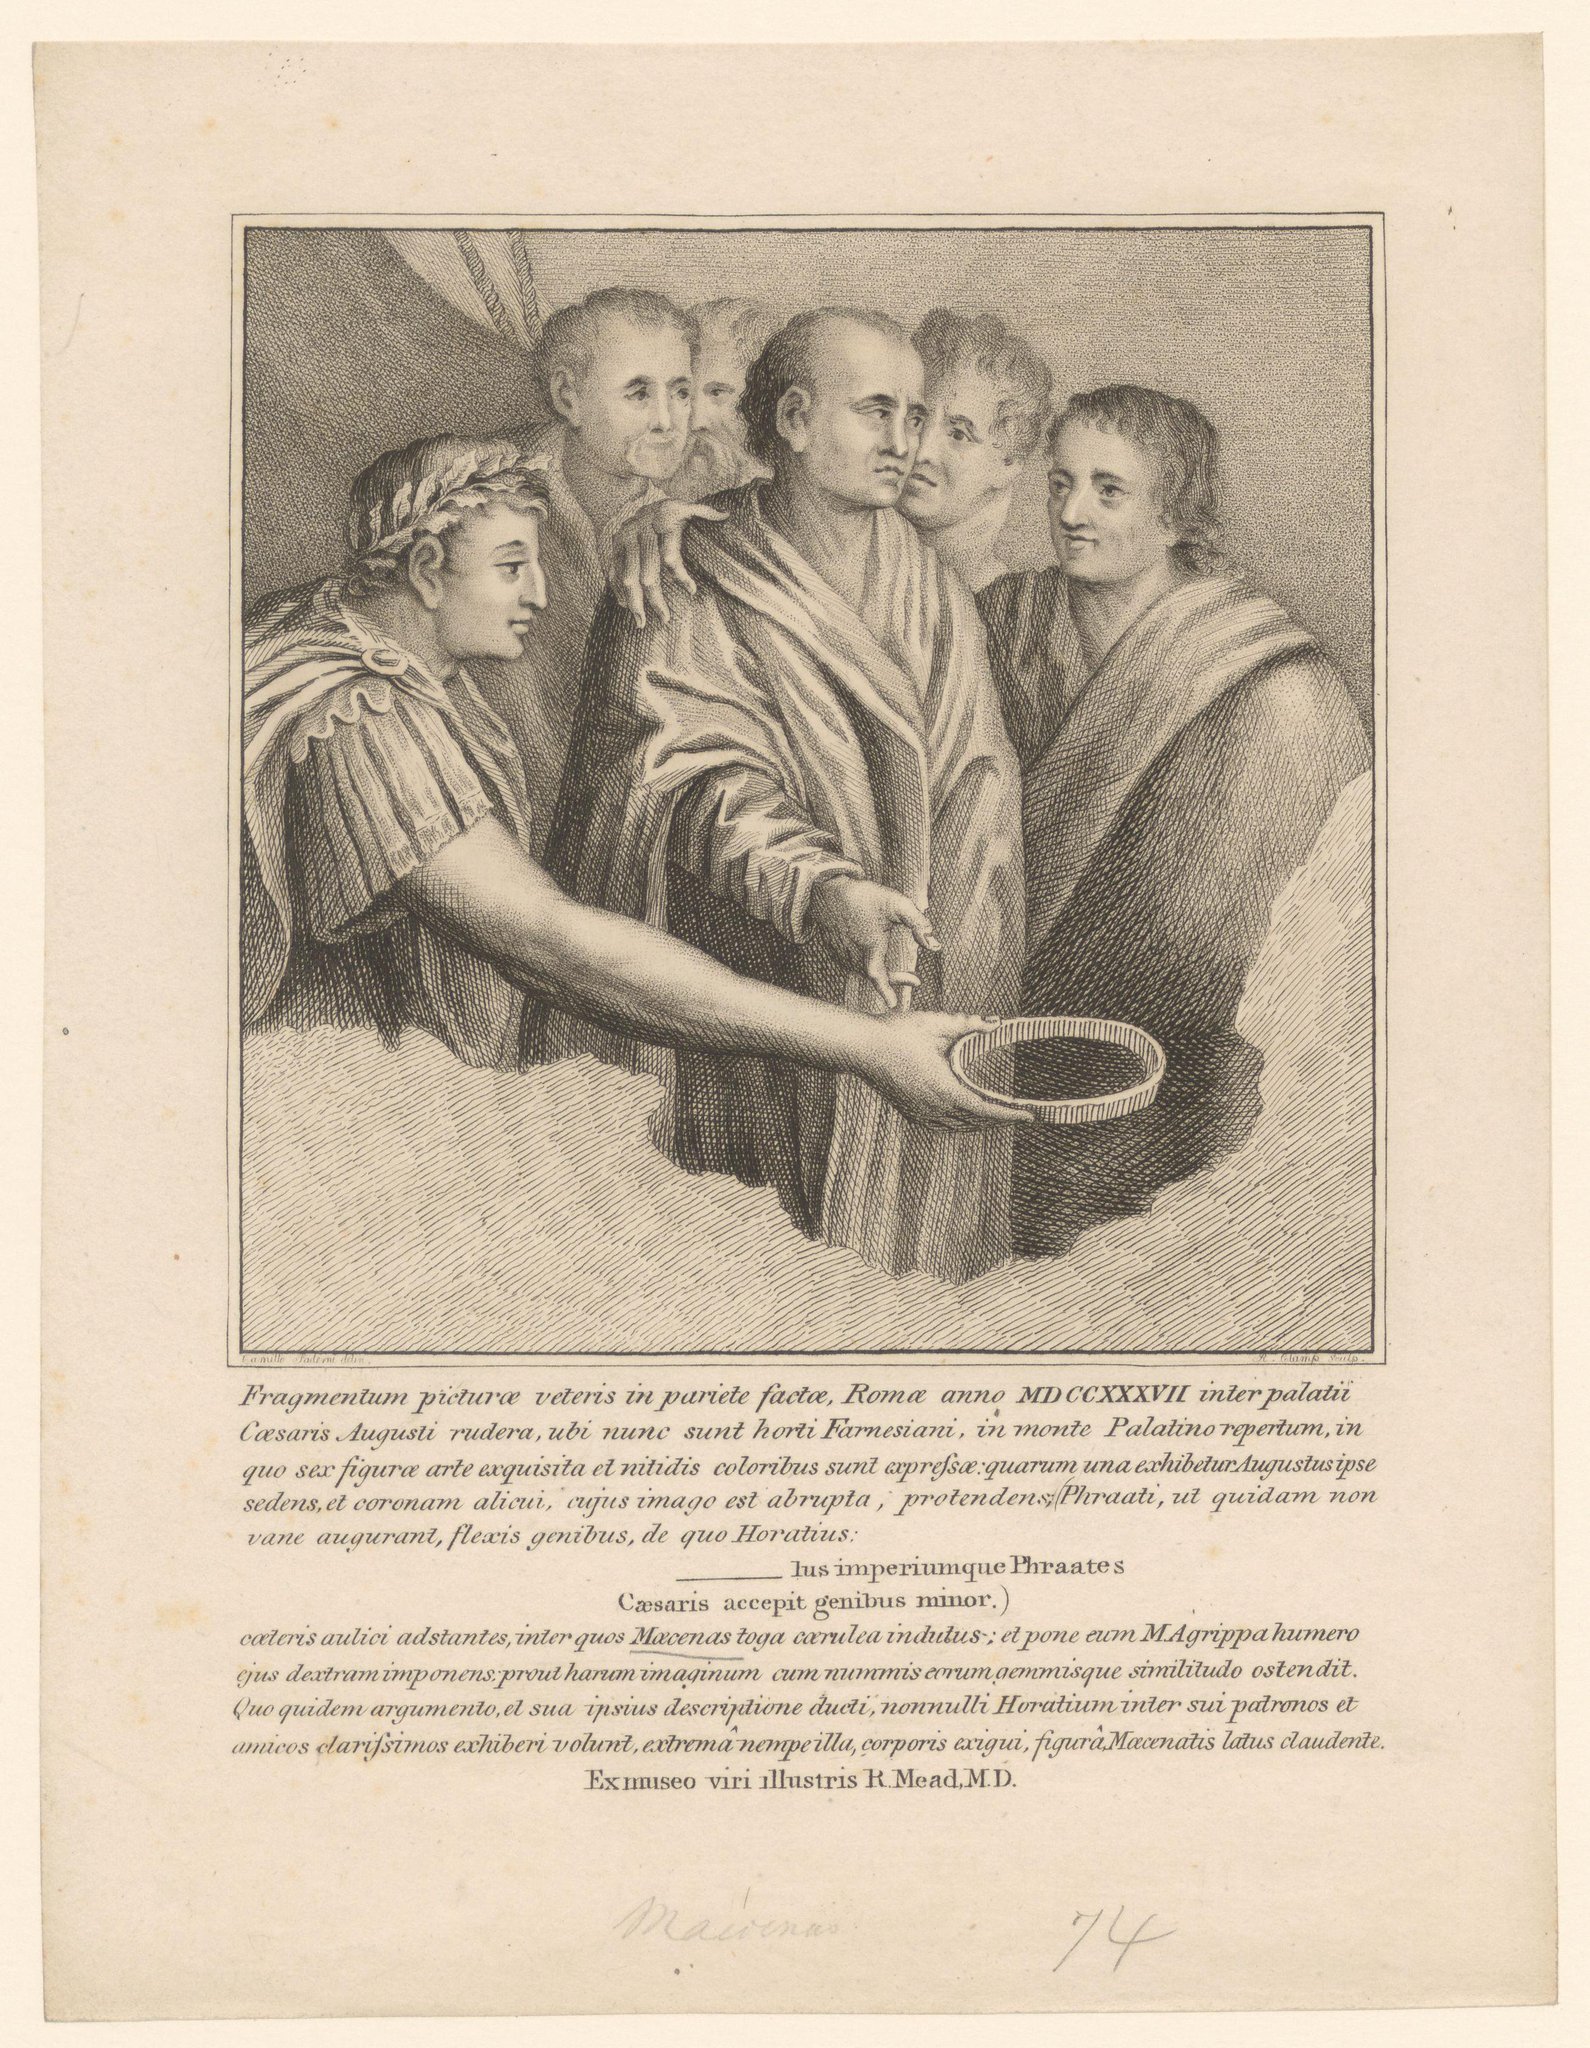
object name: print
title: Man met lauwerkrans presenteert een kroon aan vijf klassiek geklede mannen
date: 1794-1798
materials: paper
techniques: engraving, etching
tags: crown (symbol of sovereignty), historical persons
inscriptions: collector's mark: Lugt 2228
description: Prent gebruikt in: Jephson, Robert. Roman Portraits, a poem, in heroick verse; with historical remarks and illustrations. Londen: G. G. and J. Robinson, 1794.